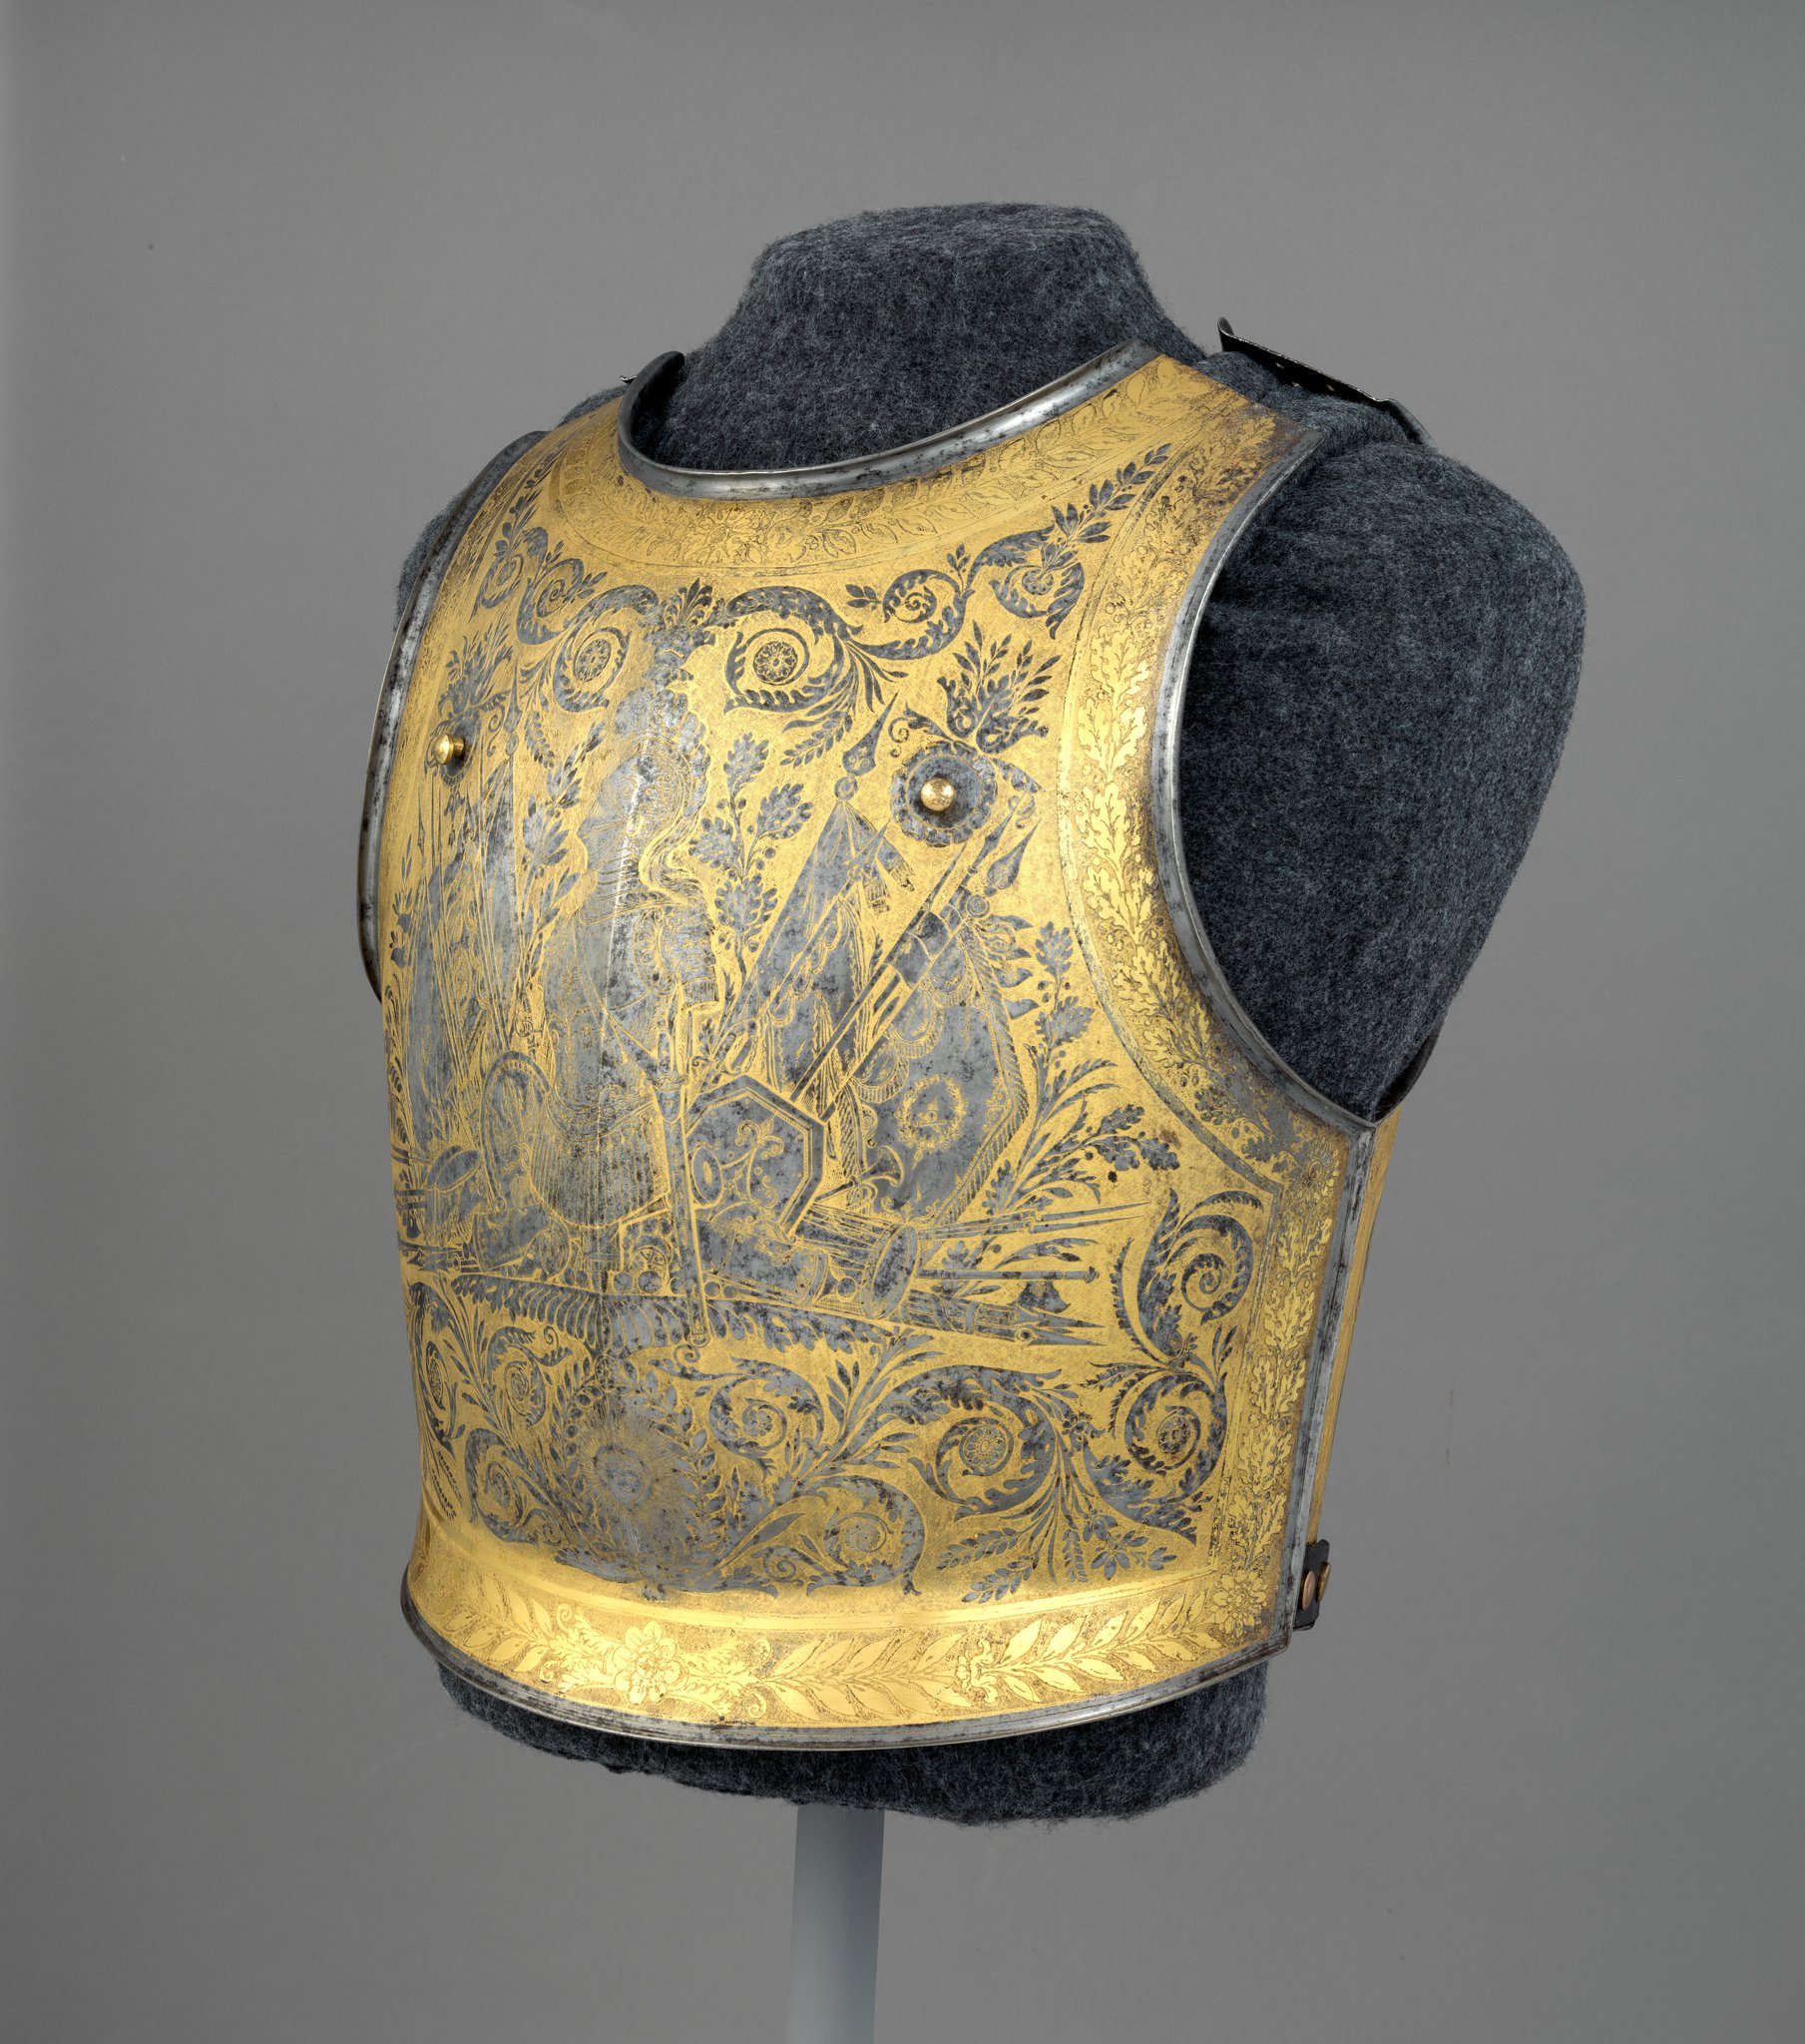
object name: cuirass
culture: french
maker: coulaux frères, manufacture royale d'armes de klingenthal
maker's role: manufactory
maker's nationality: french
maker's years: 1801-1836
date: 1825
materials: copper alloy, gold, leather, steel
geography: france